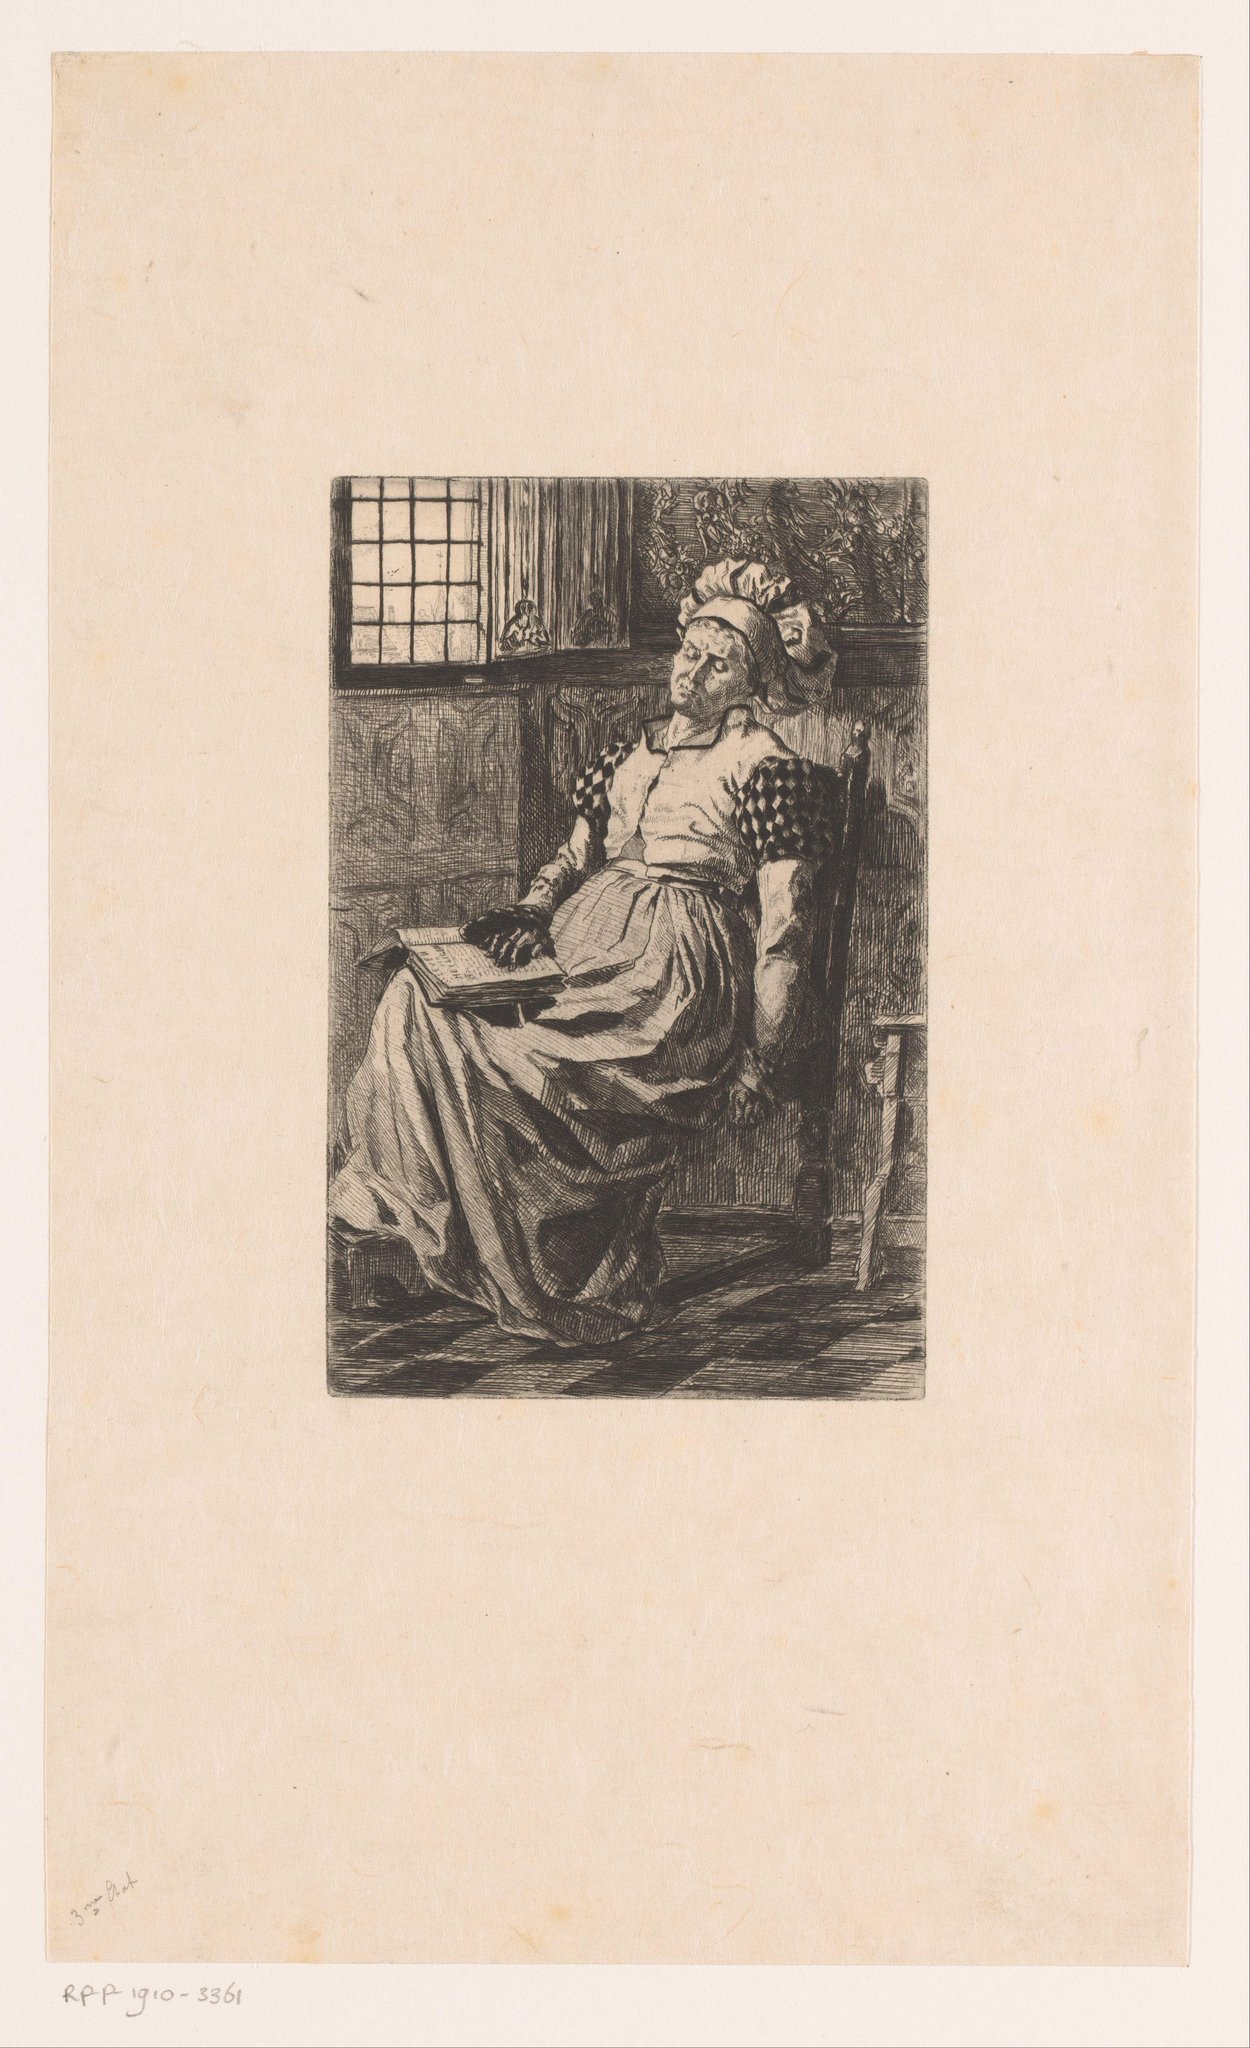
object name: print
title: Slapende vrouw op een stoel met boek op schoot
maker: willem geets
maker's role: print maker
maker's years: 1838-1919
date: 1848-1910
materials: paper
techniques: etching, intaglio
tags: sleeping in chair, book - mm - book open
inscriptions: collector's mark: Lugt 2228